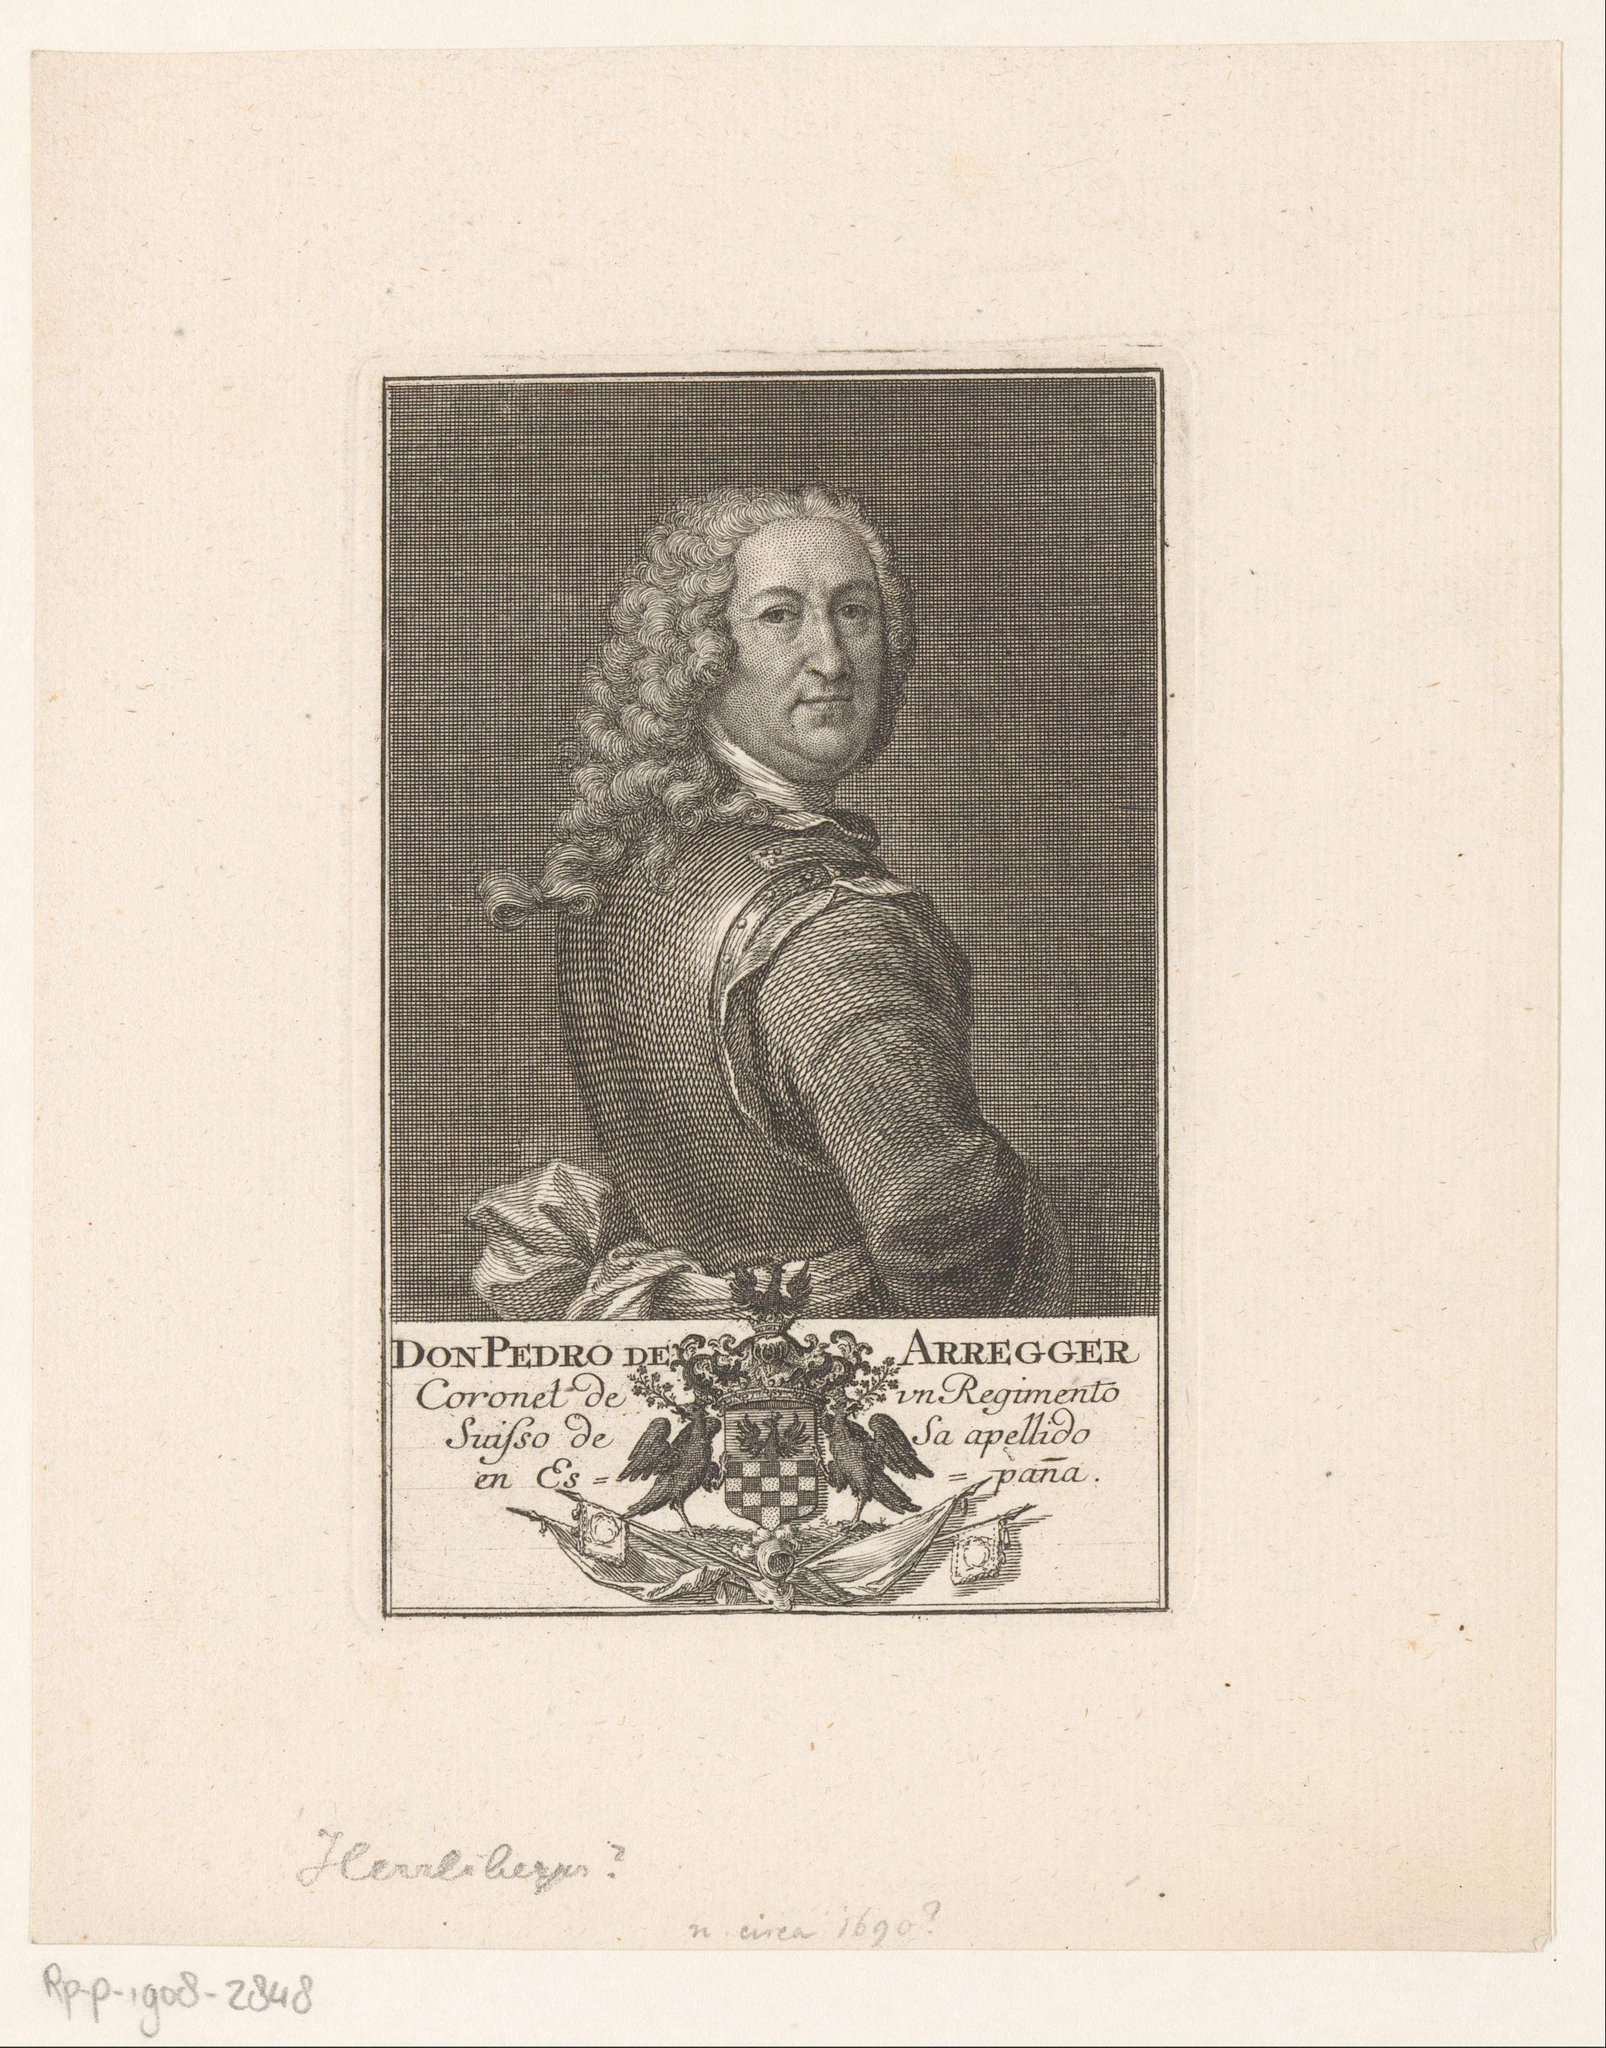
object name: print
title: Portret van Pedro de Arregger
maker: david herrliberger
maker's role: print maker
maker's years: 1697-1777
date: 1707-1736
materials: paper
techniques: engraving, etching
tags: armour, historical persons, ruler, sovereign, armorial bearing, heraldry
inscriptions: collector's mark: Lugt 2228